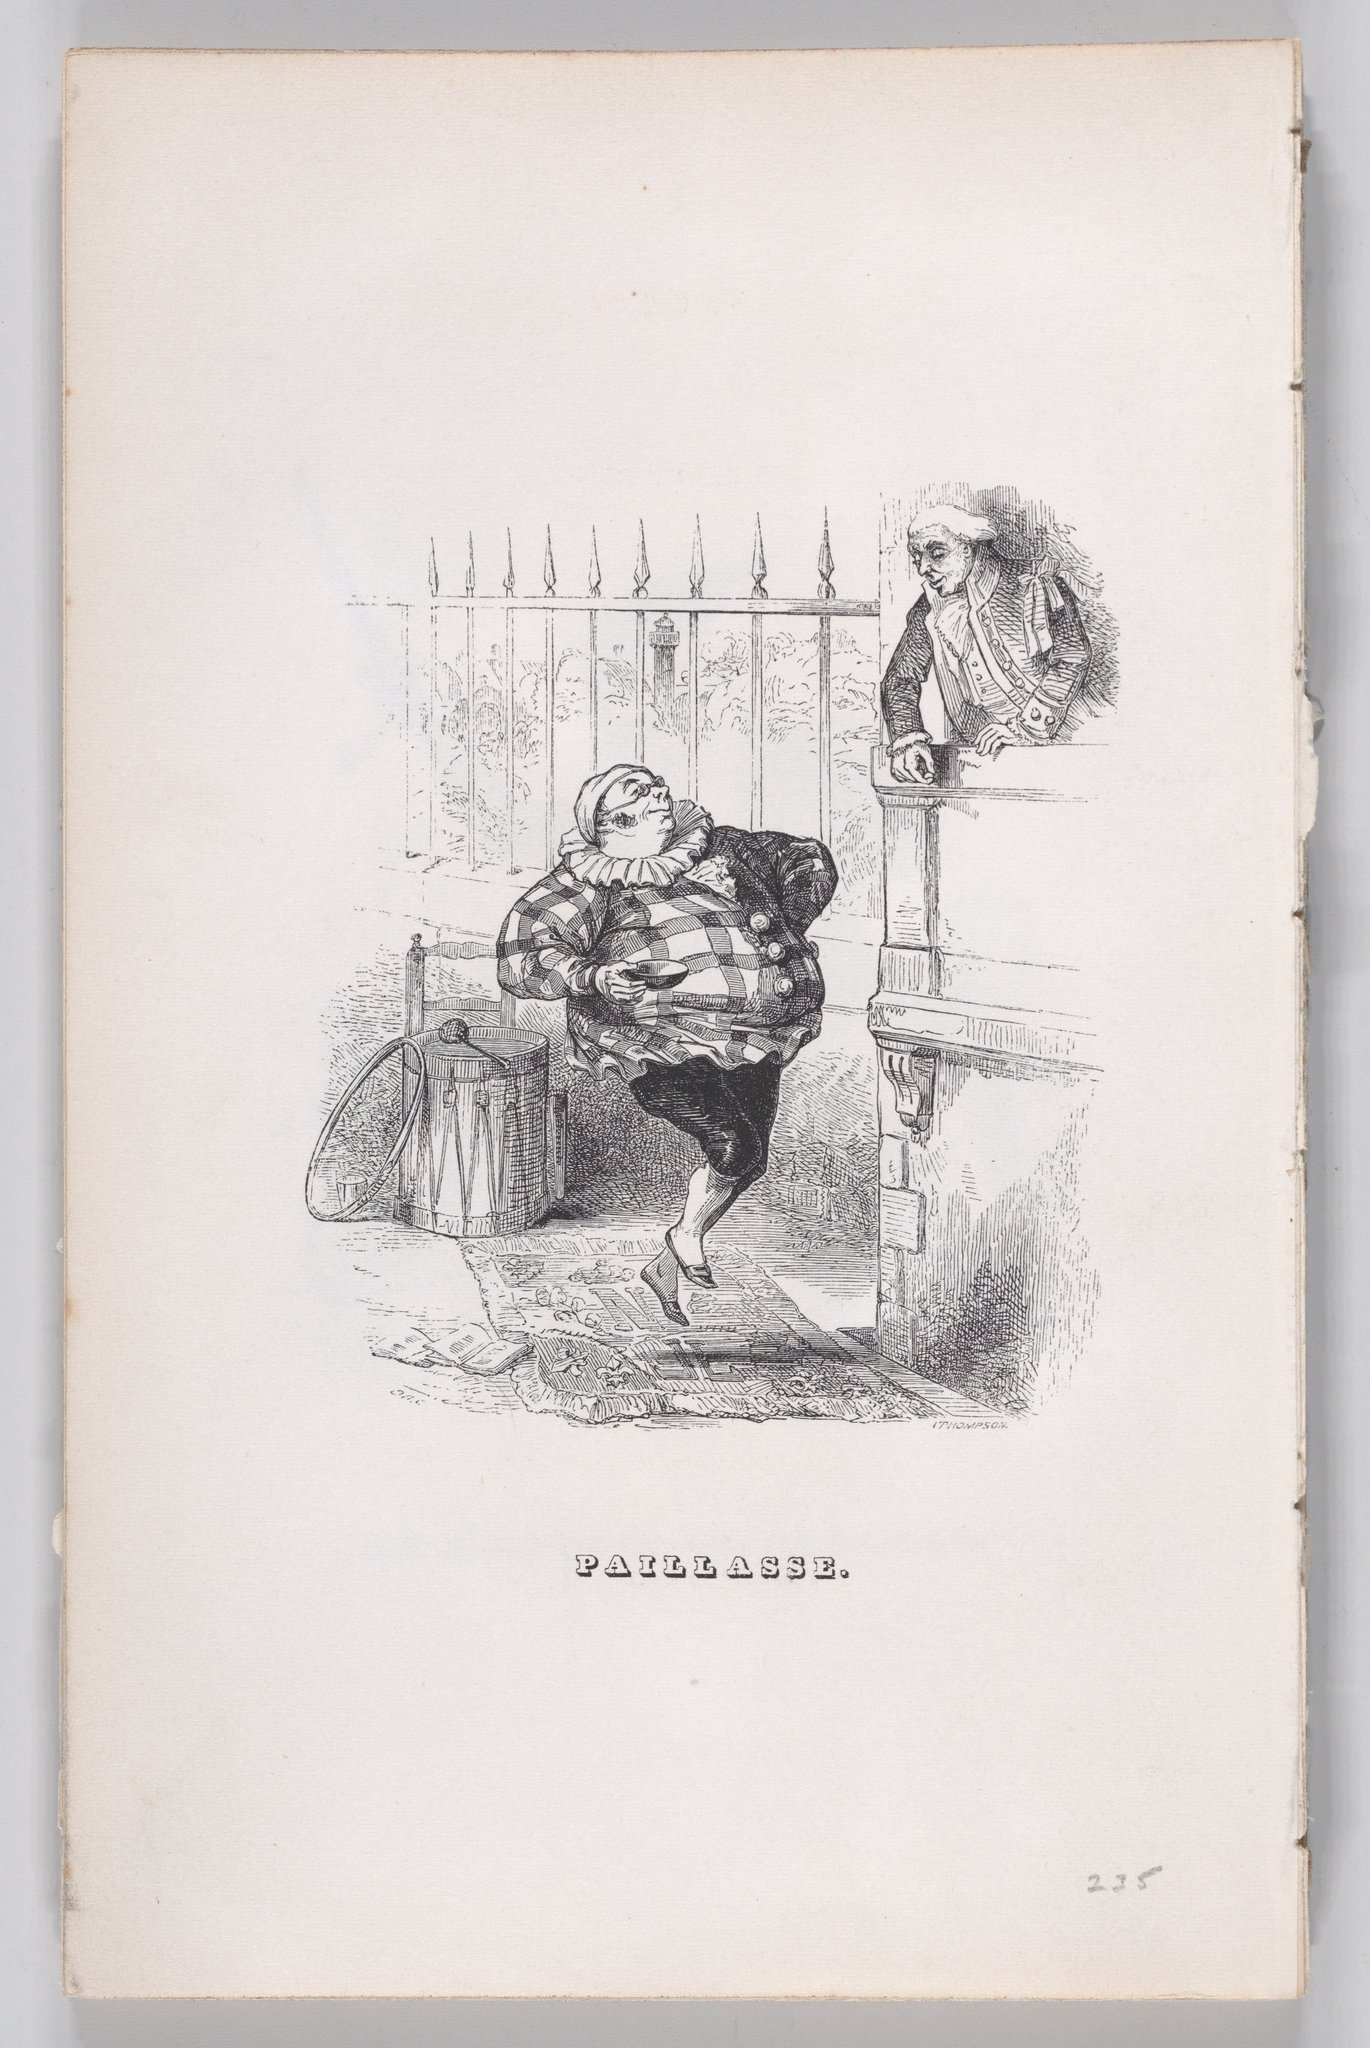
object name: print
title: Clown, from "The Complete Works of Béranger"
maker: j. j. grandville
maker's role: illustrator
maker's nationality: french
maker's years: 1803-1847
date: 1836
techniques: engraving